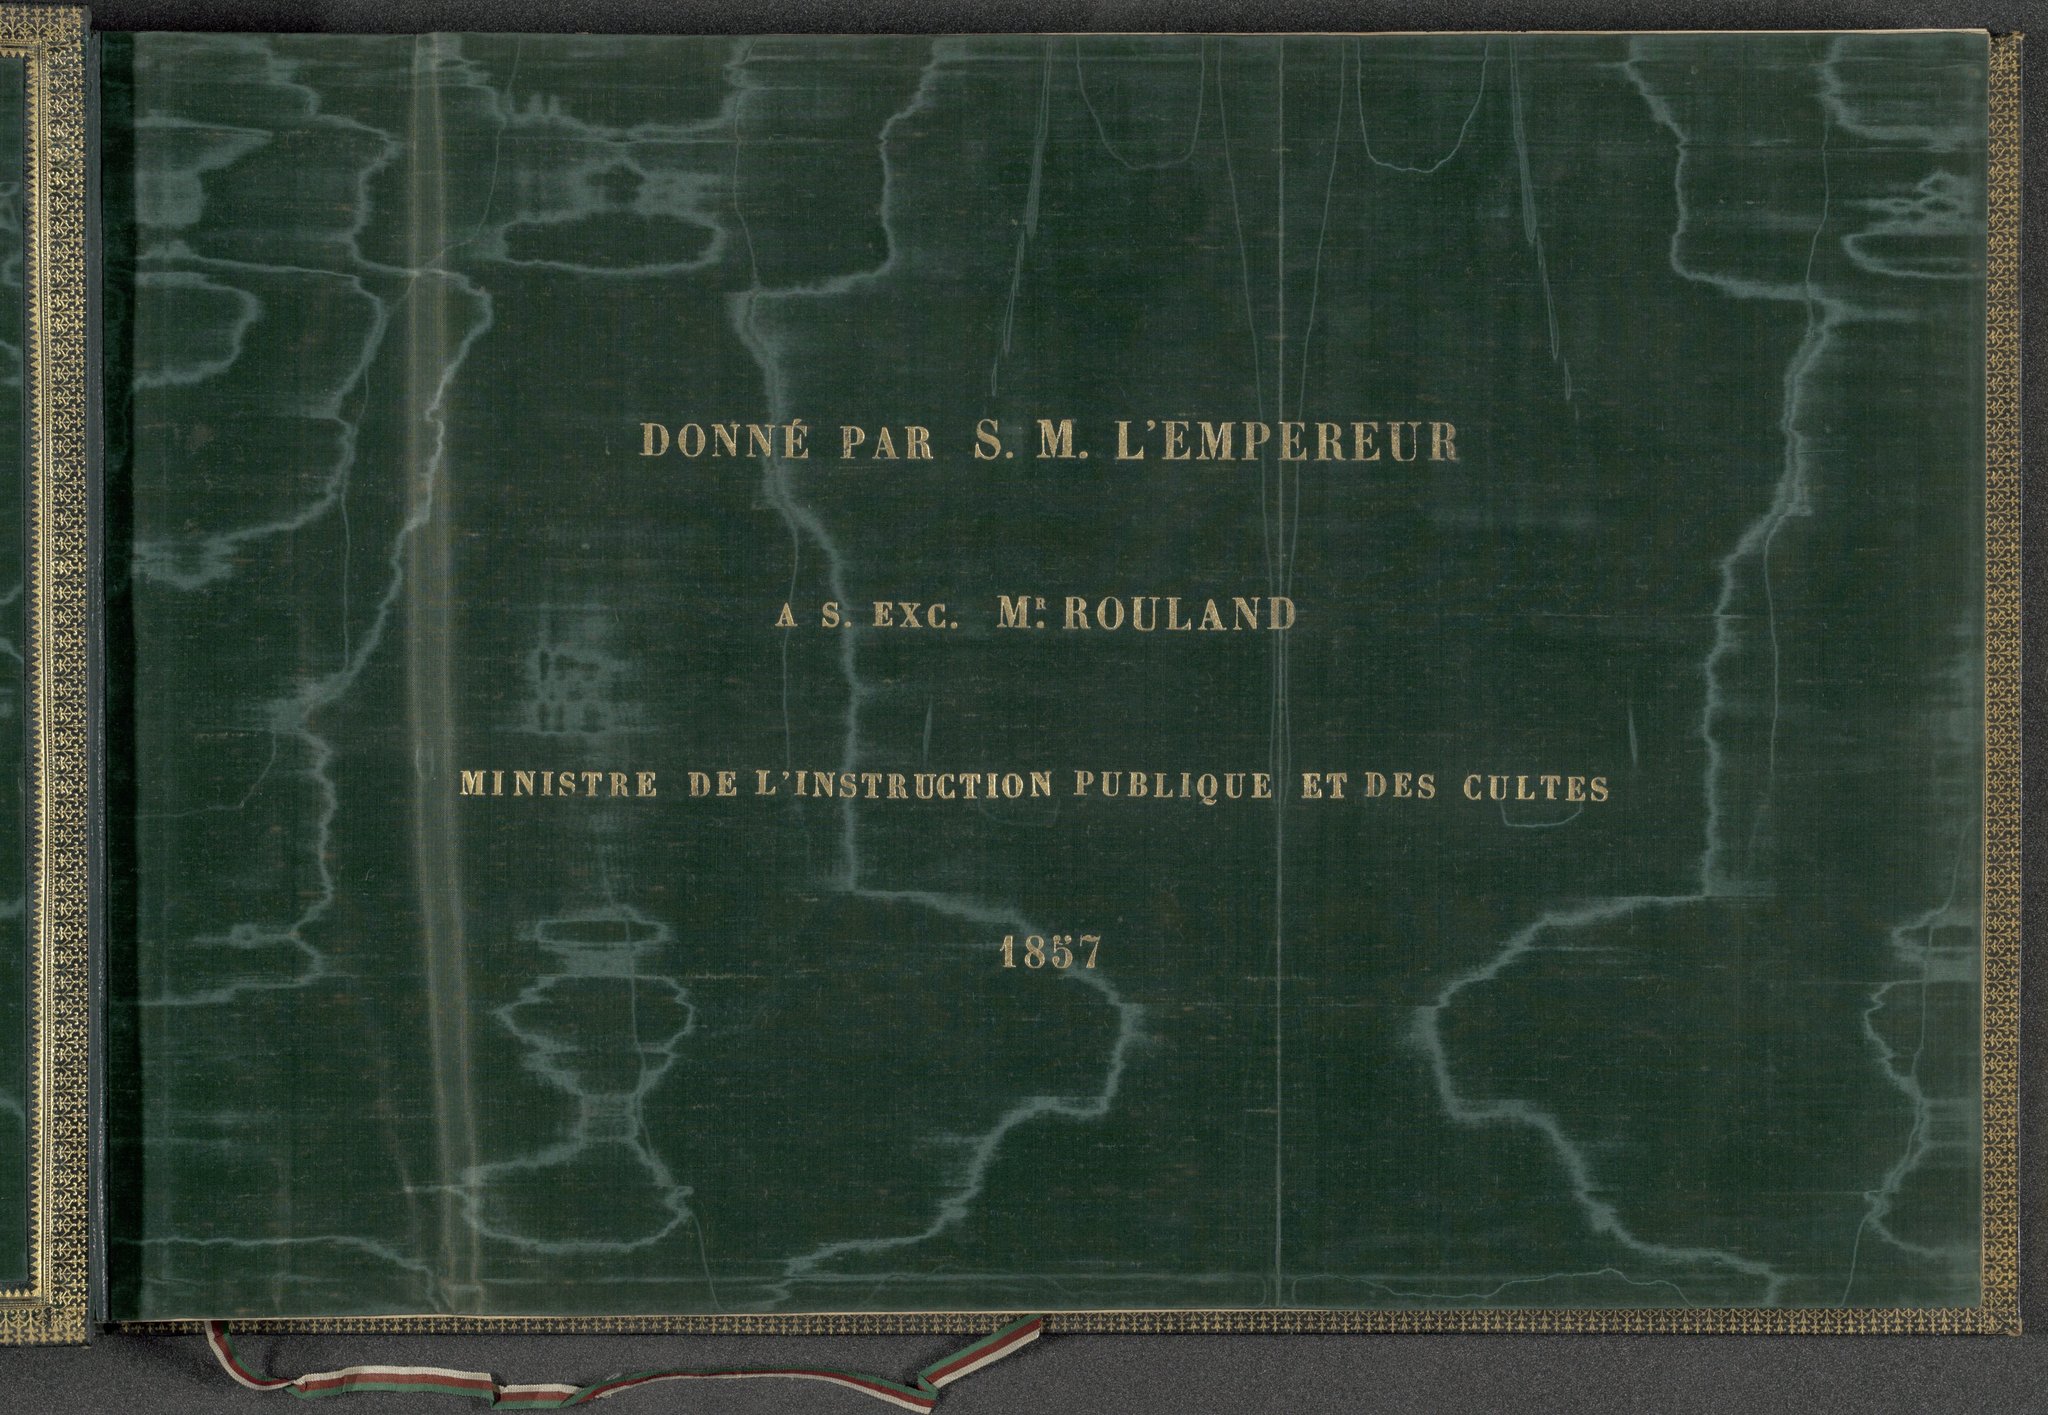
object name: album leaf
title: Namen van de schenker (keizer Napoleon III) en de ontvanger (minister Rouland) van het fotoalbum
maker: Anonymous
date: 1857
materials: paper, textile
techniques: printing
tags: permanent exhibition, museum, paris, tuileries palace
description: Onderdeel van Réunion des Tuileries au Louvre 1852-1857, album 4.